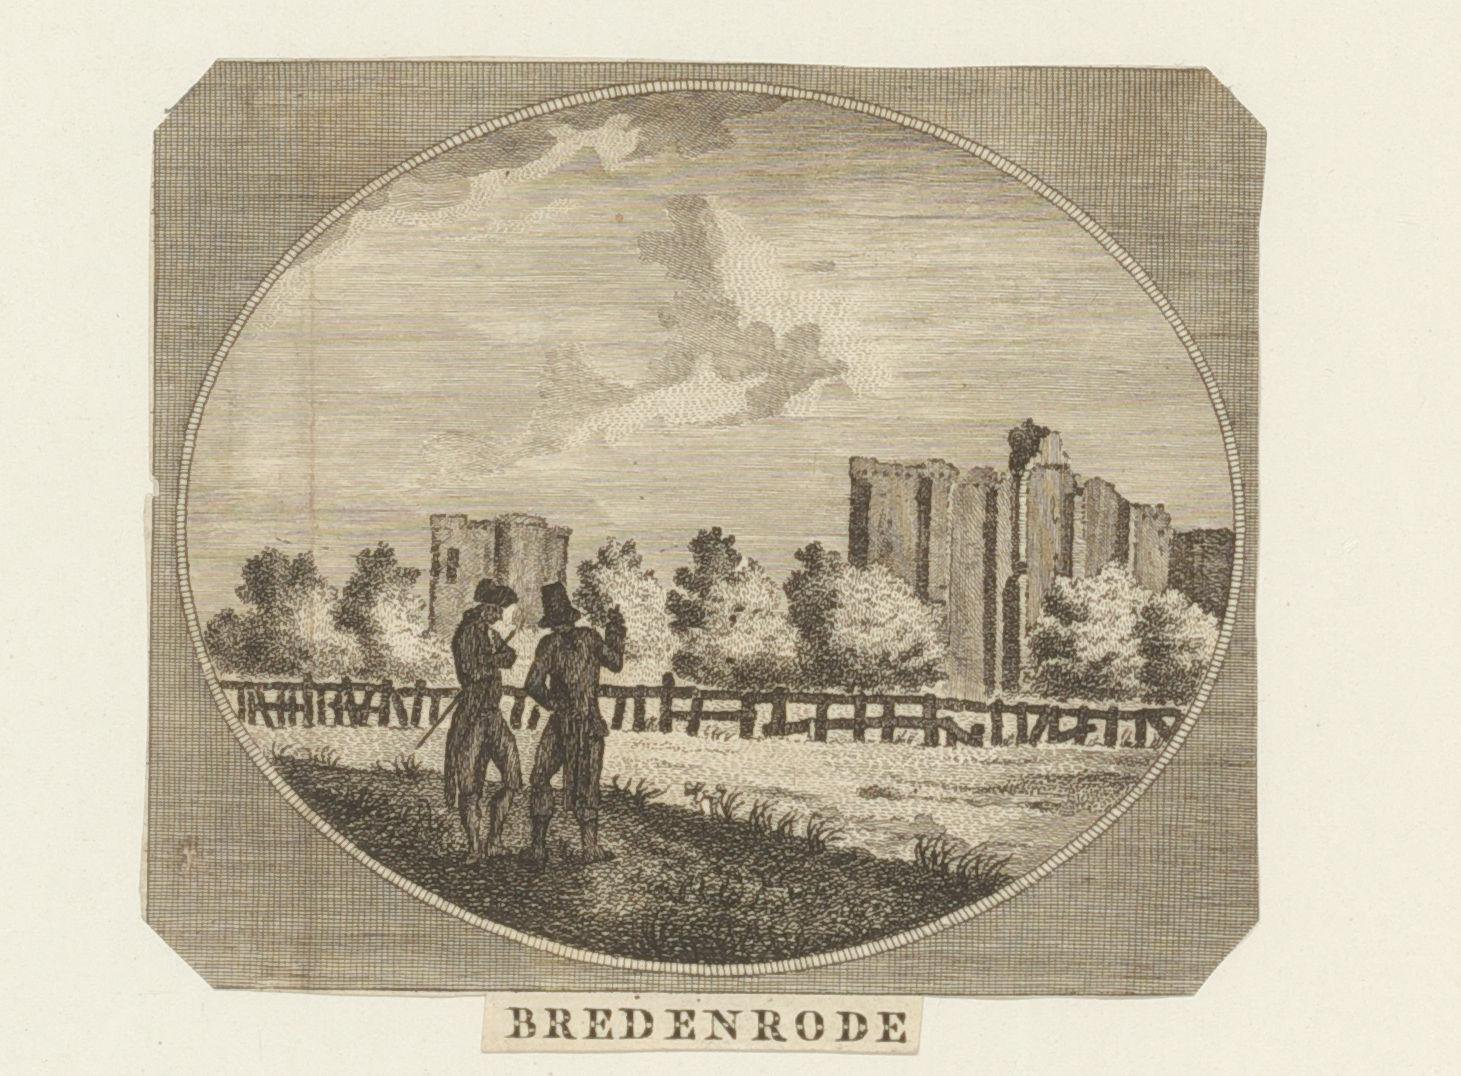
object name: print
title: Gezicht op de ruïne van Huis Brederode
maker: Anonymous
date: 1700-1799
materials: paper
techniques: etching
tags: ruin of a dwelling, house, castle, etc., haarlem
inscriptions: collector's mark: Lugt 1641, stamp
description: Onderwerpsrubrieken binnen de Atlas Zeden en Gewoonten: Zeden en gewoonten in Engeren zin, De woning, Kastelen en buitenplaatsen.